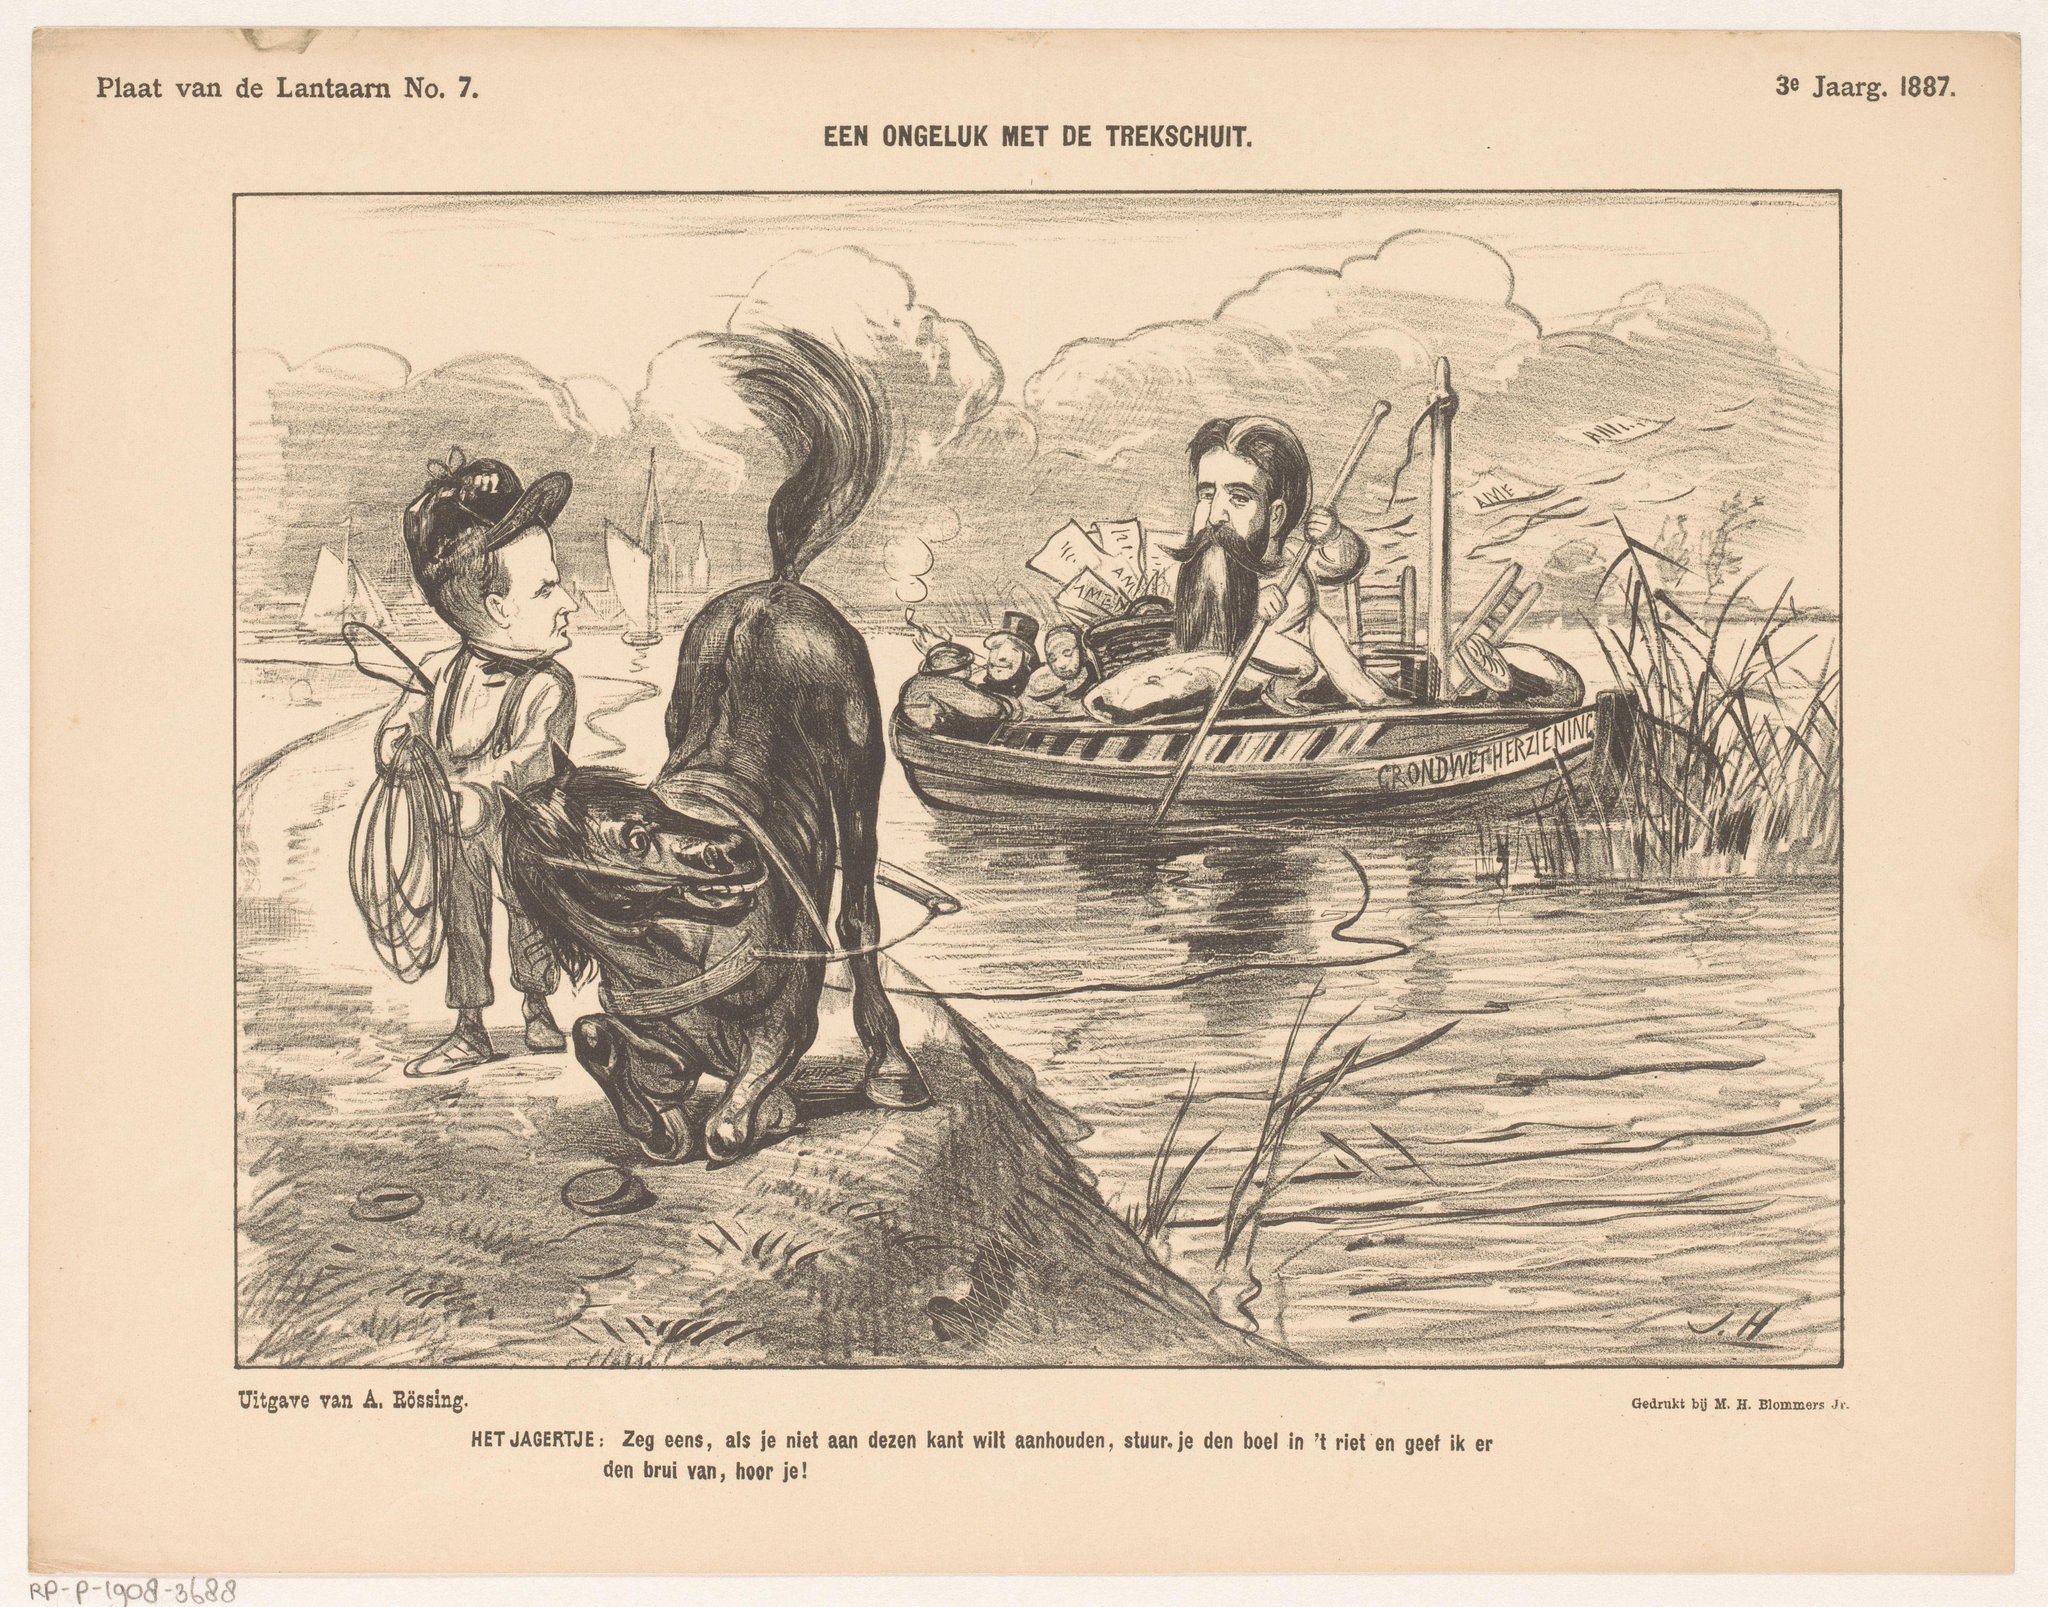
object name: print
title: Spotprent met jager te paard met trekschuit in het riet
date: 1887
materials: paper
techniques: lithograph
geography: the hague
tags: tow-boat, towing-barge, horse, political caricatures and satires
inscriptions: collector's mark: Lugt 2228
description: De jager probeert de trekschuit uit het riet te krijgen. De scène verwijst naar de mislukte herzieningen van de grondwet in 1887. Deze prent werd uitgegeven bij De Lantaarn en ging vooraf aan plaat no. 8.